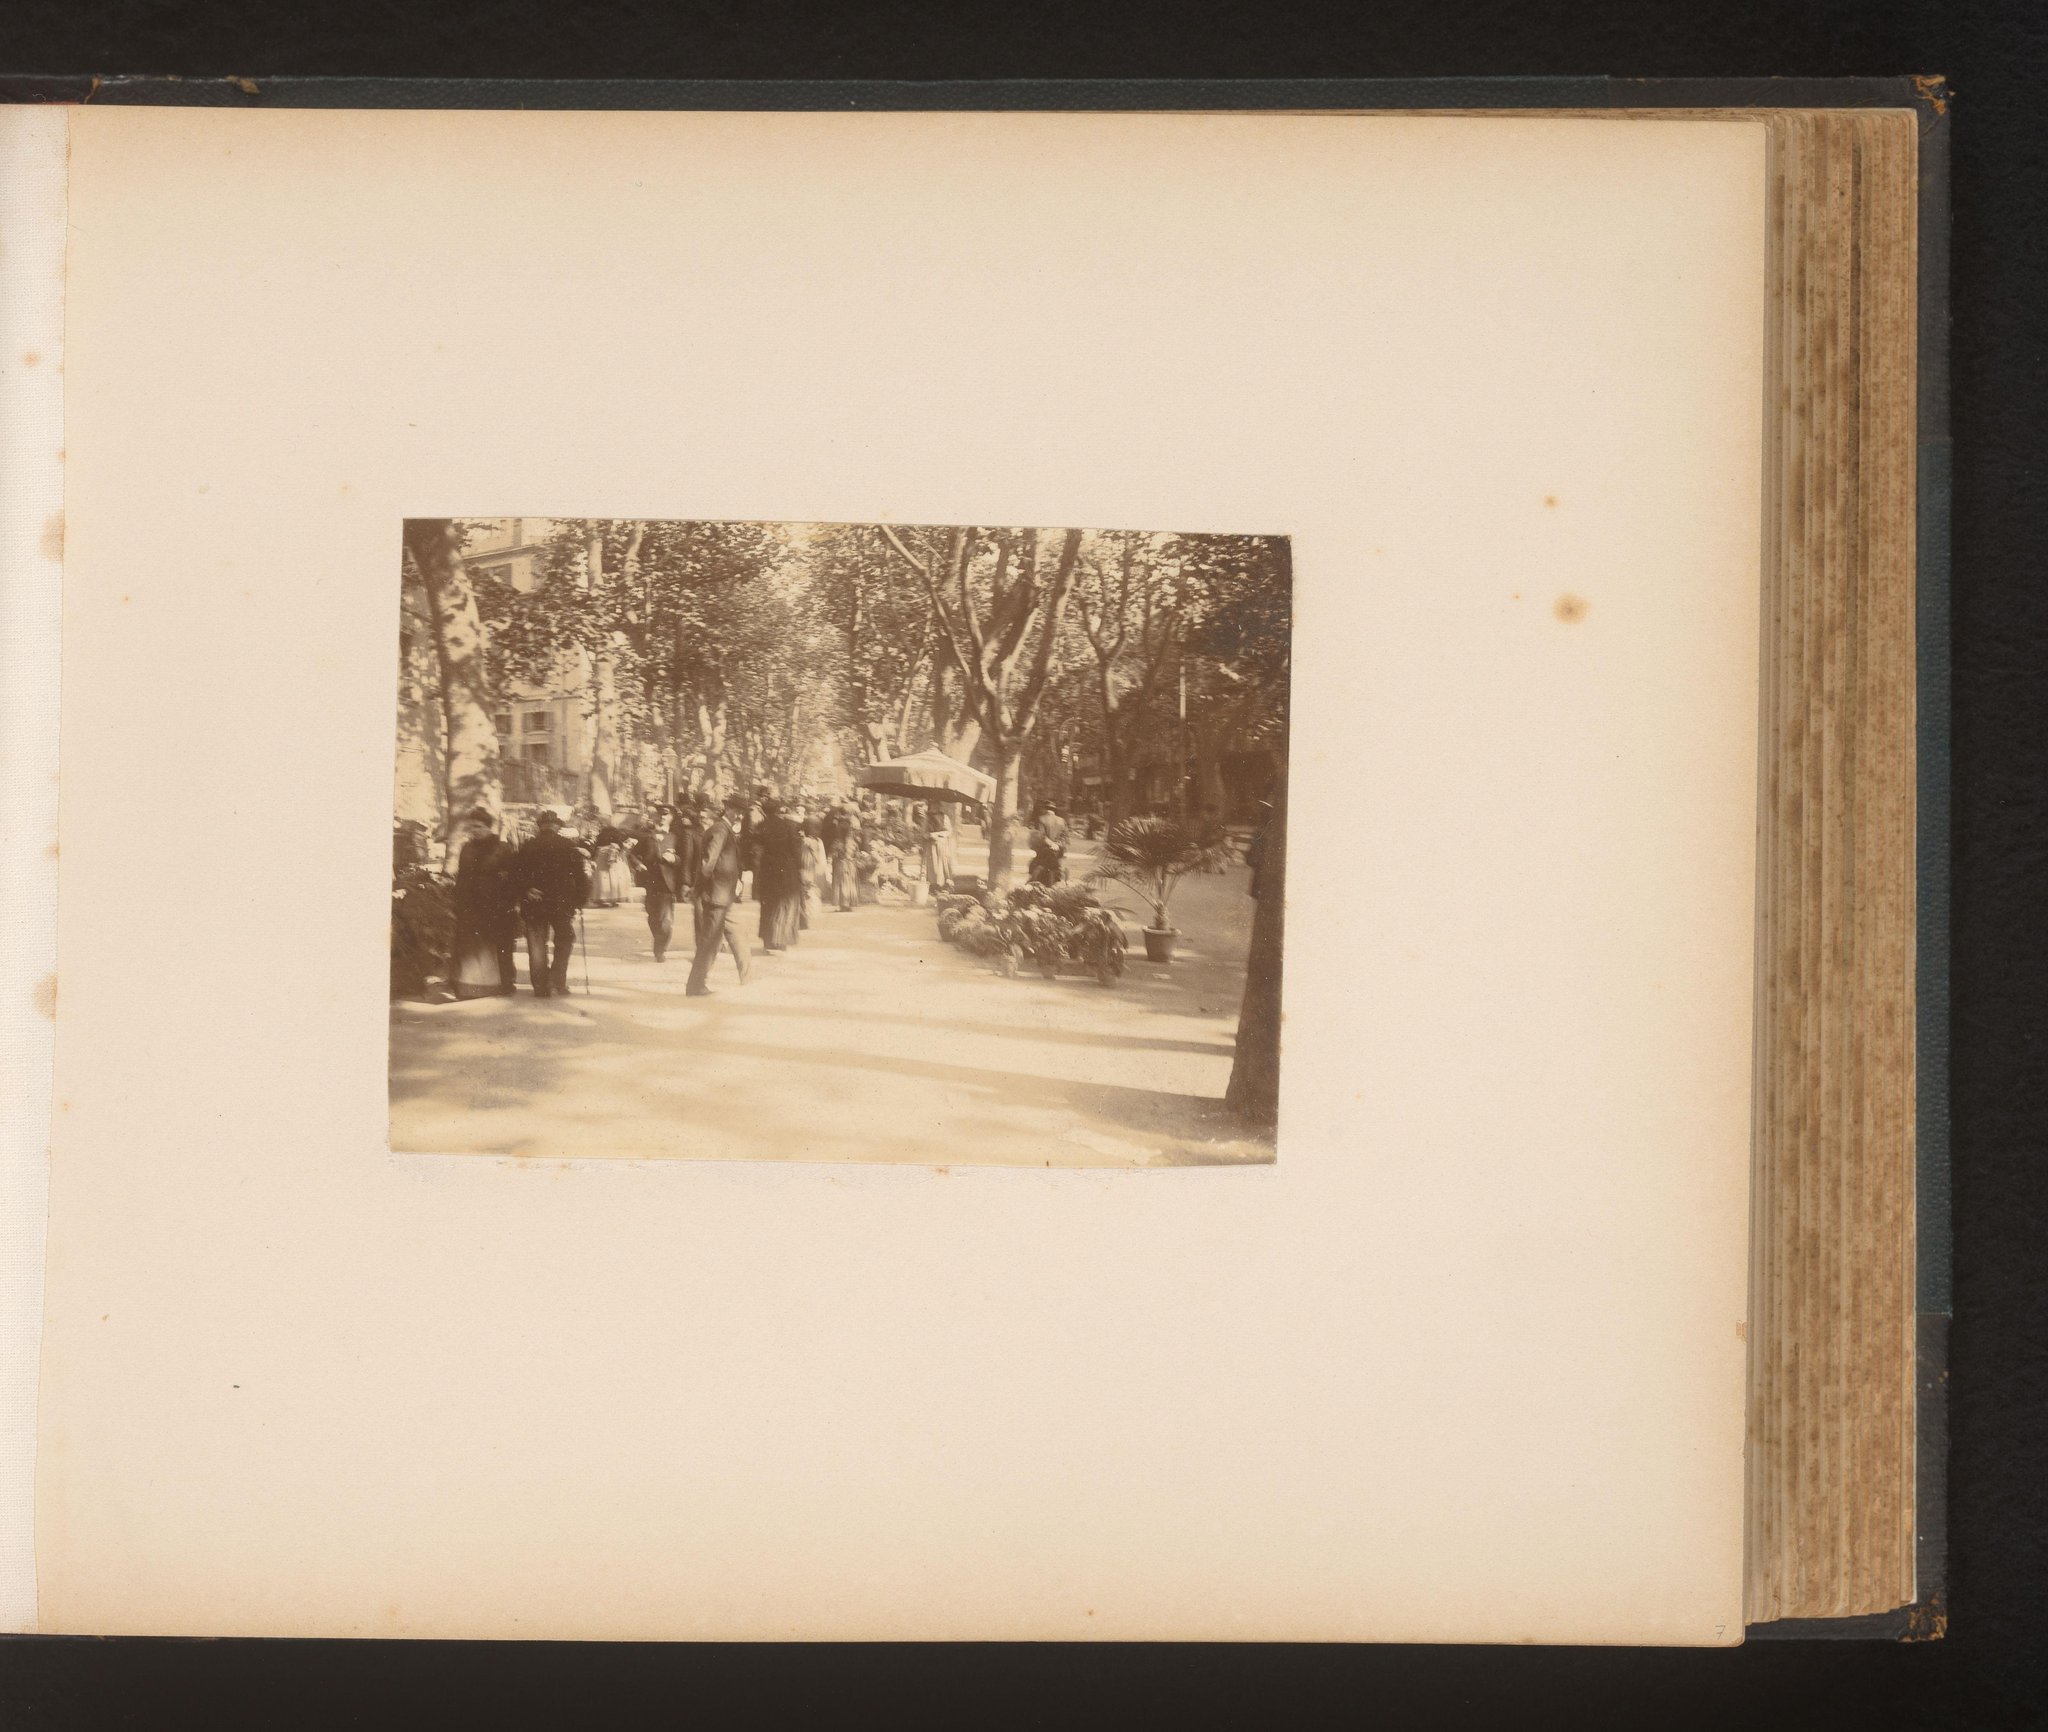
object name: photograph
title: Straatgezicht te Frankrijk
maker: Anonymous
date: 1880-1920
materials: cardboard, photographic support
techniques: gelatin silver print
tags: trees, historical persons, street, france